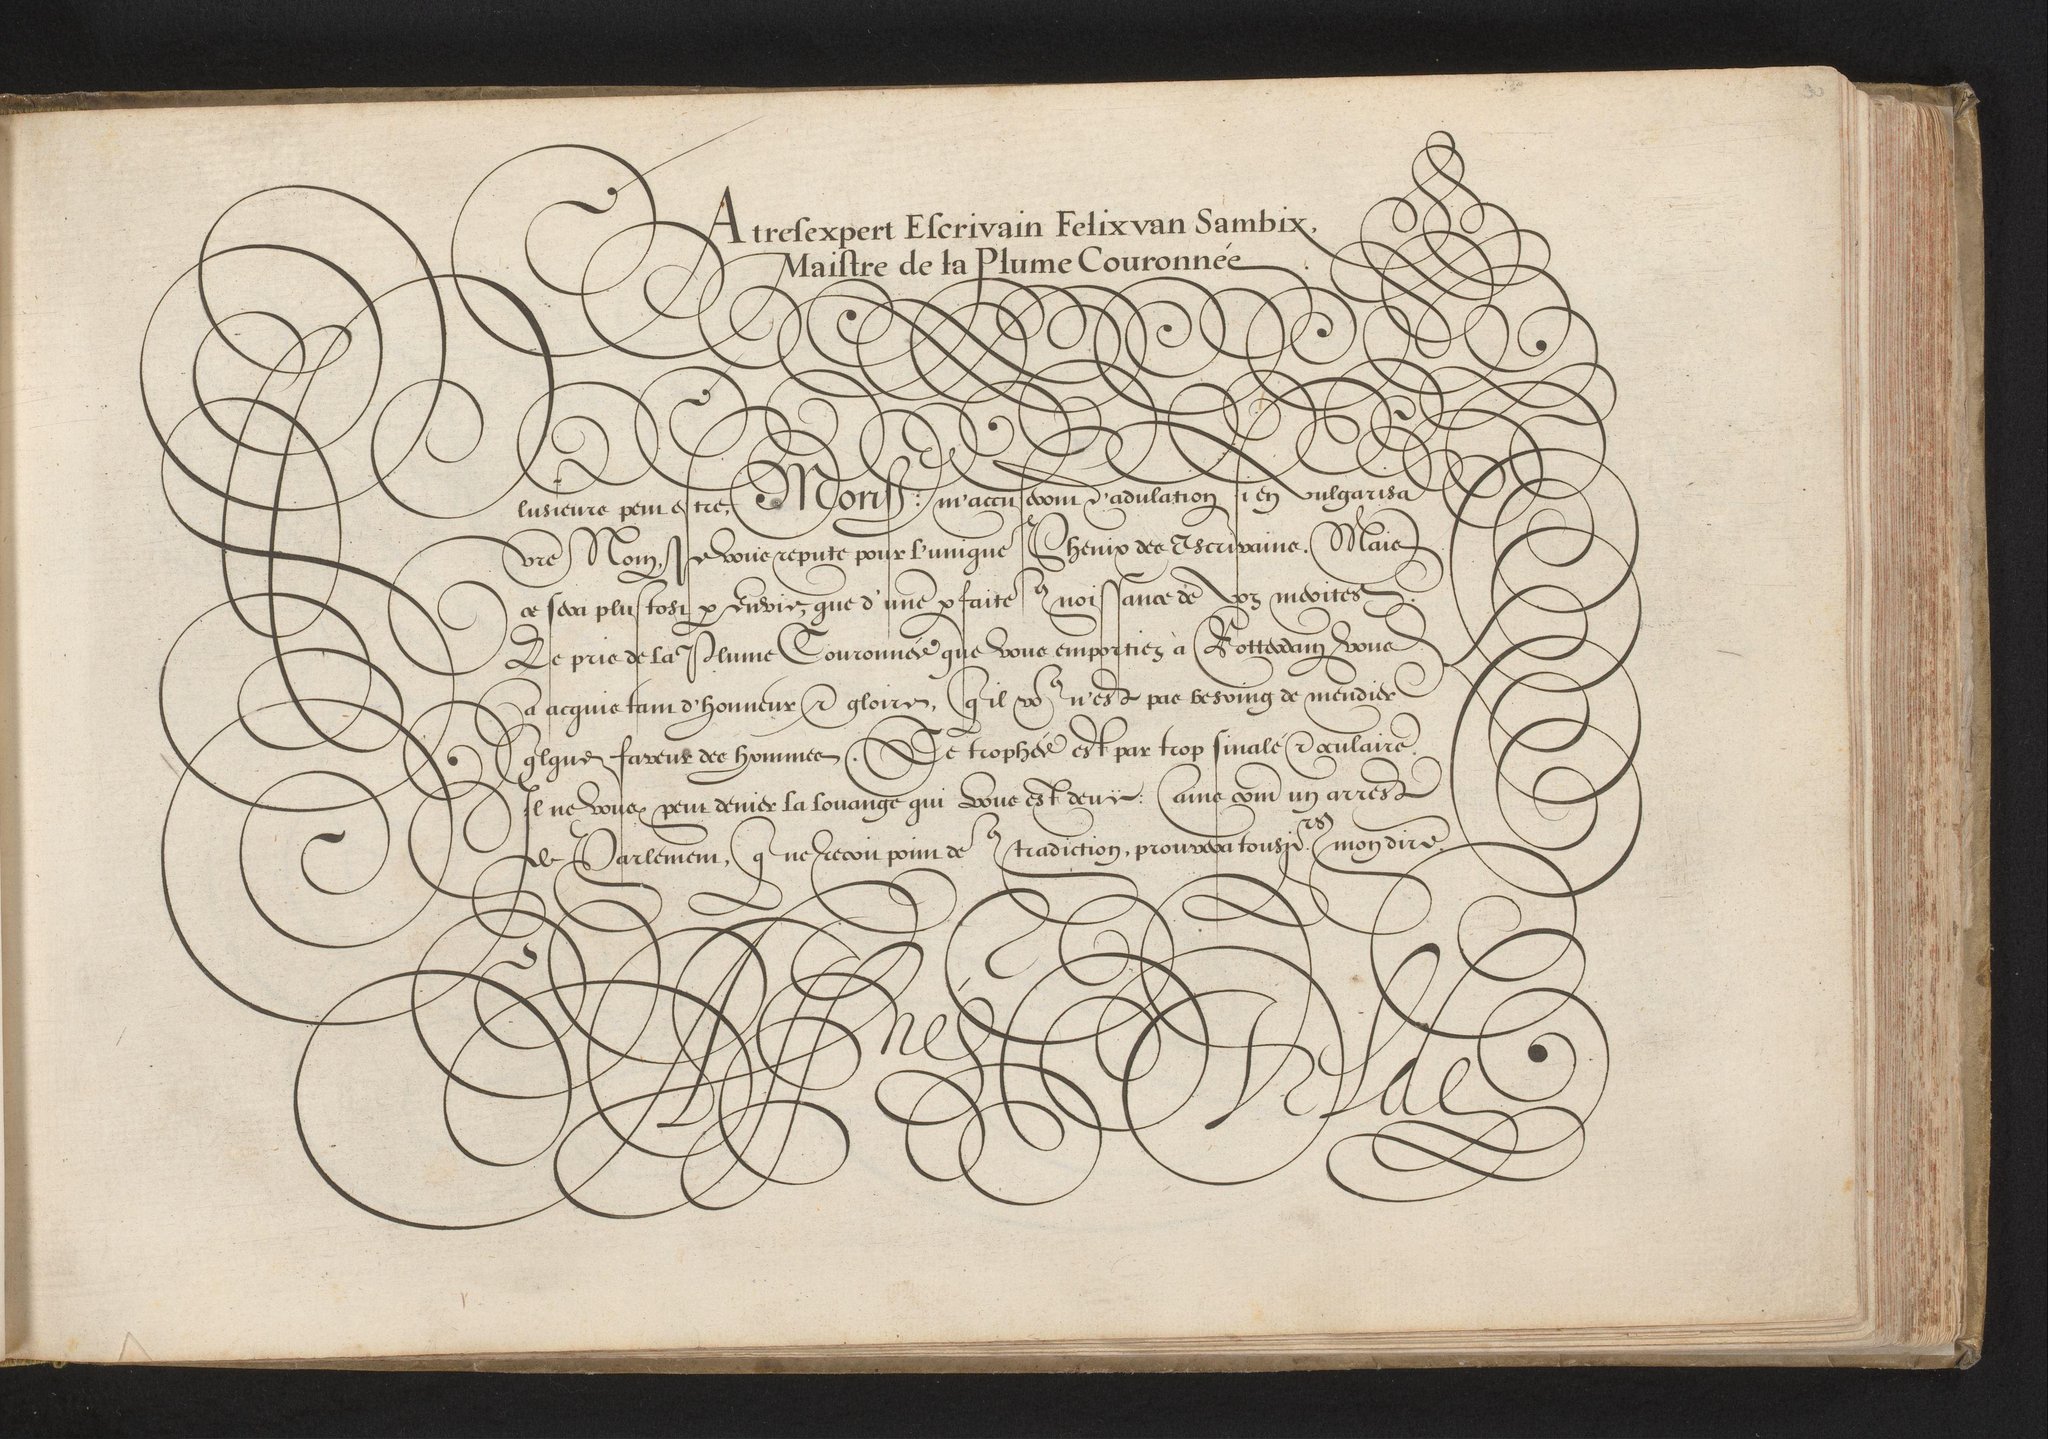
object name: album leaf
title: Schrijfvoorbeeld: A tres expert (...)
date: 1605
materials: paper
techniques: engraving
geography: haarlem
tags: calligraphy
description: Schrijfvoorbeeld met de aanhef: A tres expert escrivain Felix van Sambix. Maistre de la Plume Couronnée. Daaronder in een andere letter een initiaal P en acht regels tekst in het Frans: Plusieure peut estre ... Onderaan: Aisné Velde. De tekst is omlijst door krulwerk. De prent maakt deel uit van een album.